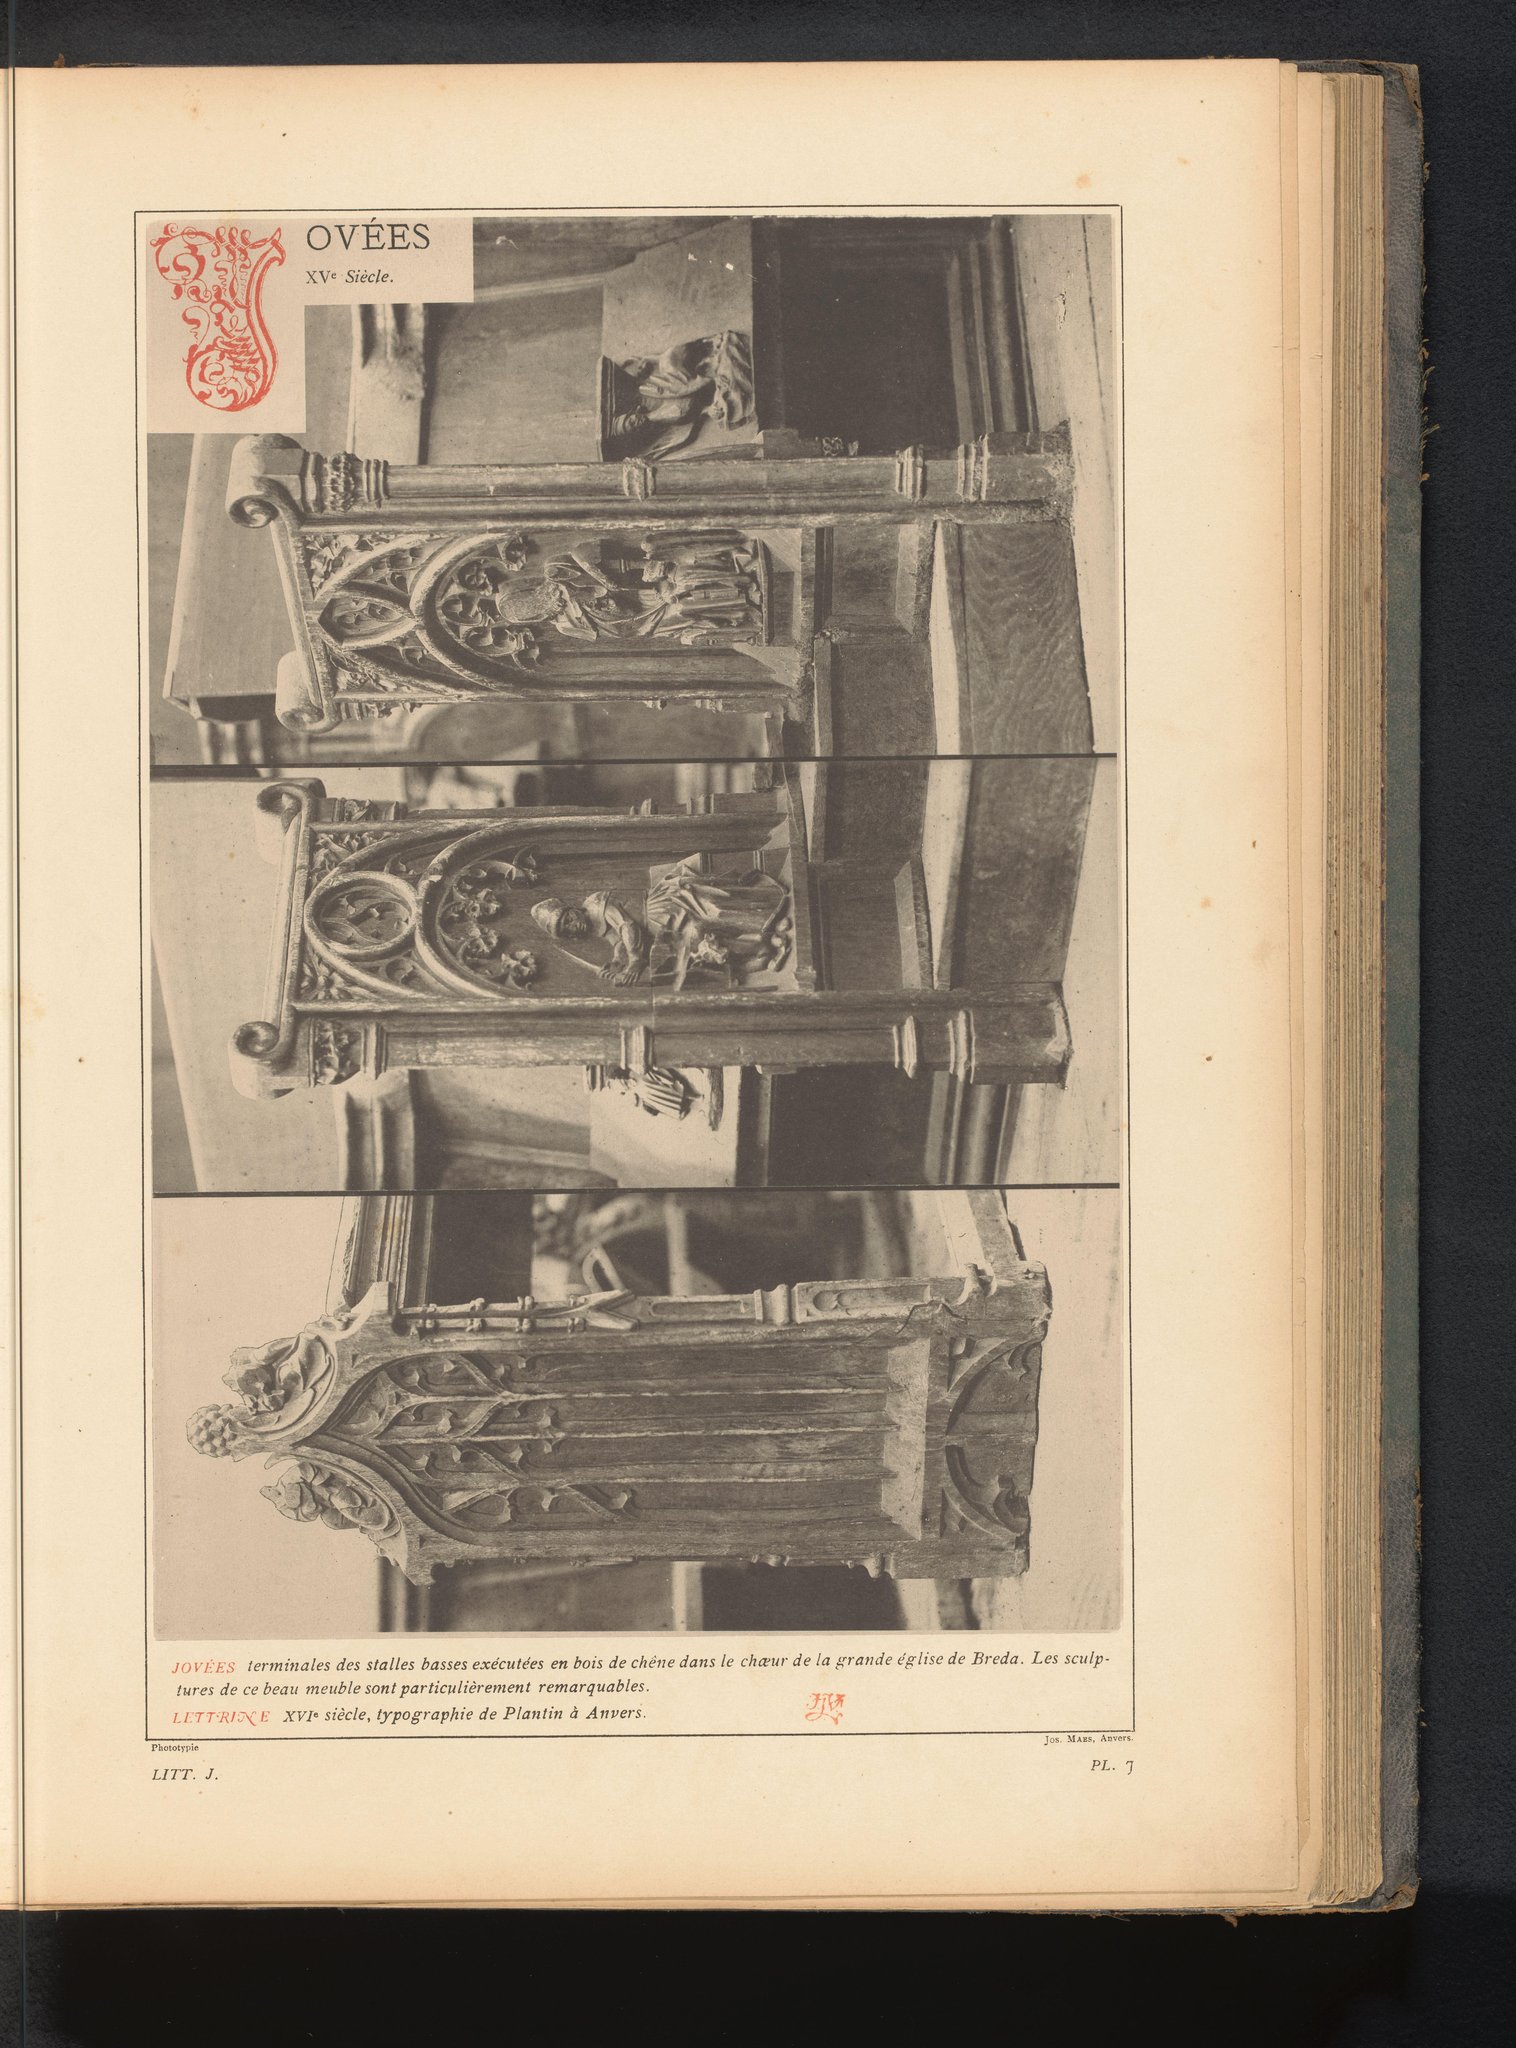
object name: page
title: Drie gedecoreerde eikenhouten zijkanten van kerkbanken in de Grote Kerk van Breda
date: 1875-1880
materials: paper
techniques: photograph, photolithography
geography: antwerp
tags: liturgical furniture, etc.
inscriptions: inscription: ‘Jovées terminales des (...)’, monogram: ‘JJvY’, inscription: ‘LITT. J. - PL. 7’